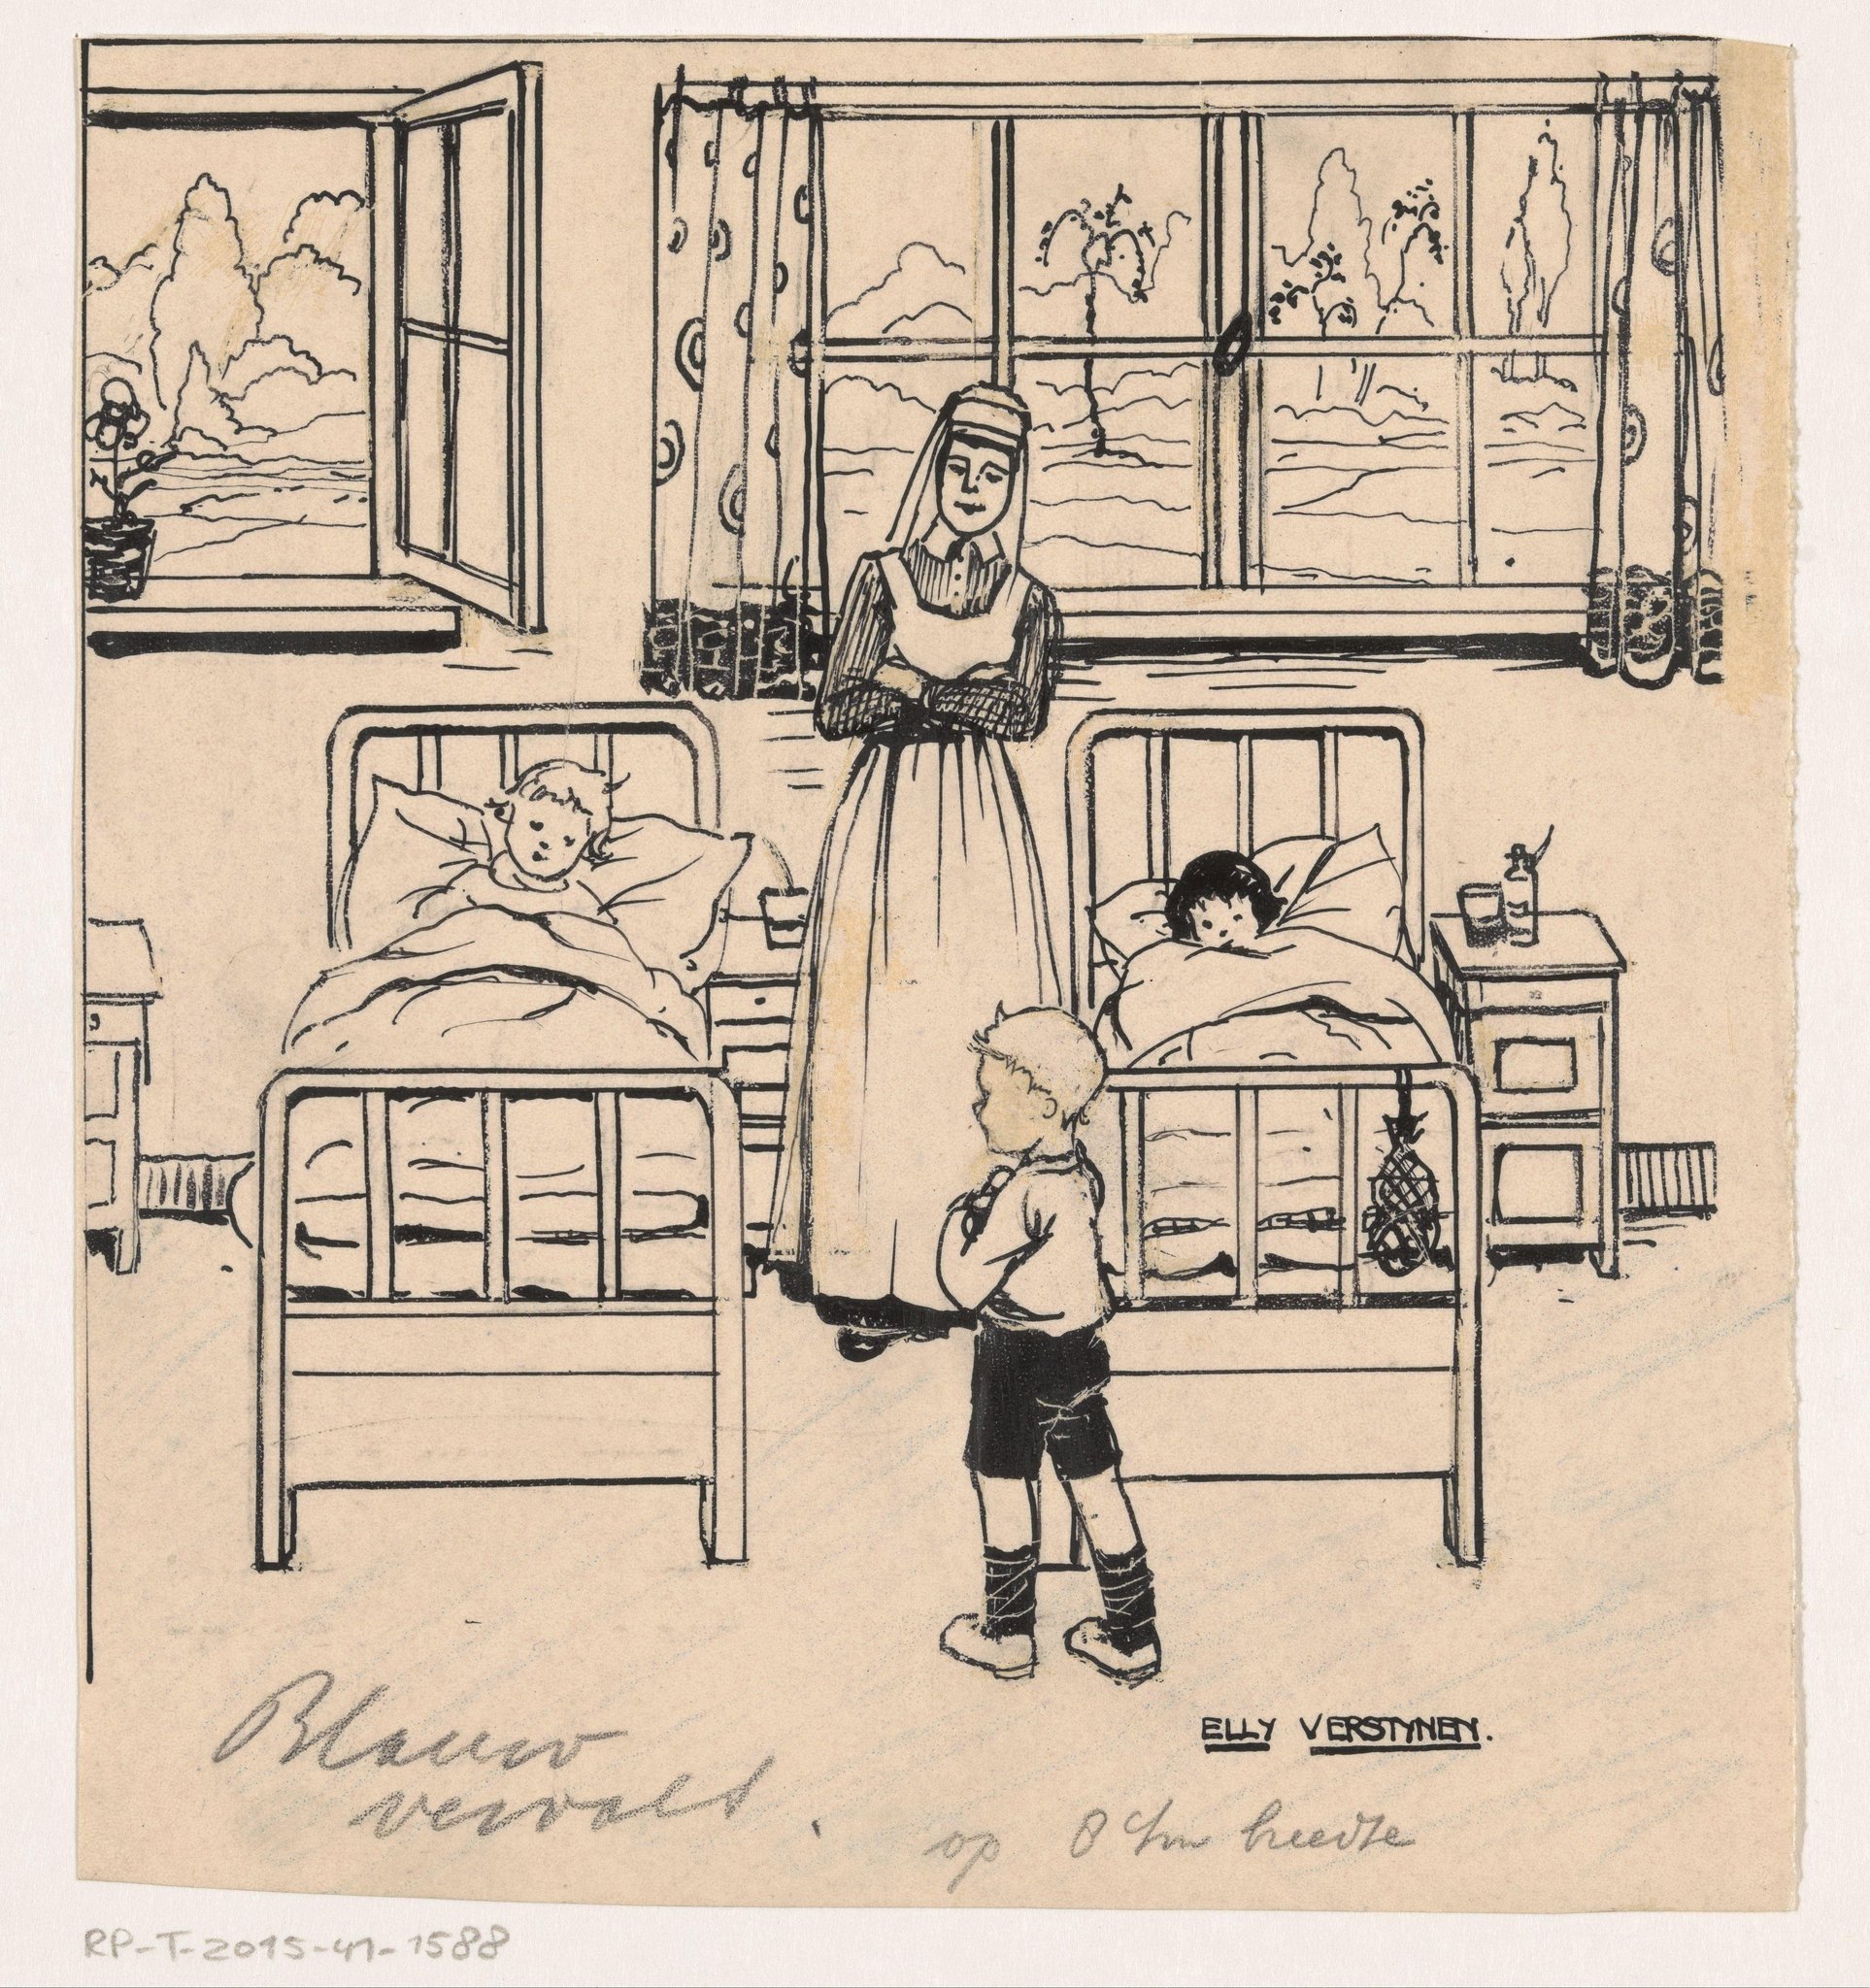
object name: drawing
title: Zuster op een ziekenzaal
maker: elly verstijnen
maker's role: draughtsman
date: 1900-1930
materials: ink, paper, pencil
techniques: pen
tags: nurse ~ hospital, ward; room (in hospital)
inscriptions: signature: ‘ELLY VERSTYNEN.’, collector's mark: Lugt 2228, :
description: Op een ziekenzaal liggen twee kinderen in bed. Een zuster staat tussen de twee bedden in en kijkt naar een jongen die aan komt lopen. Door de ramen is een landschap met bomen te zien.